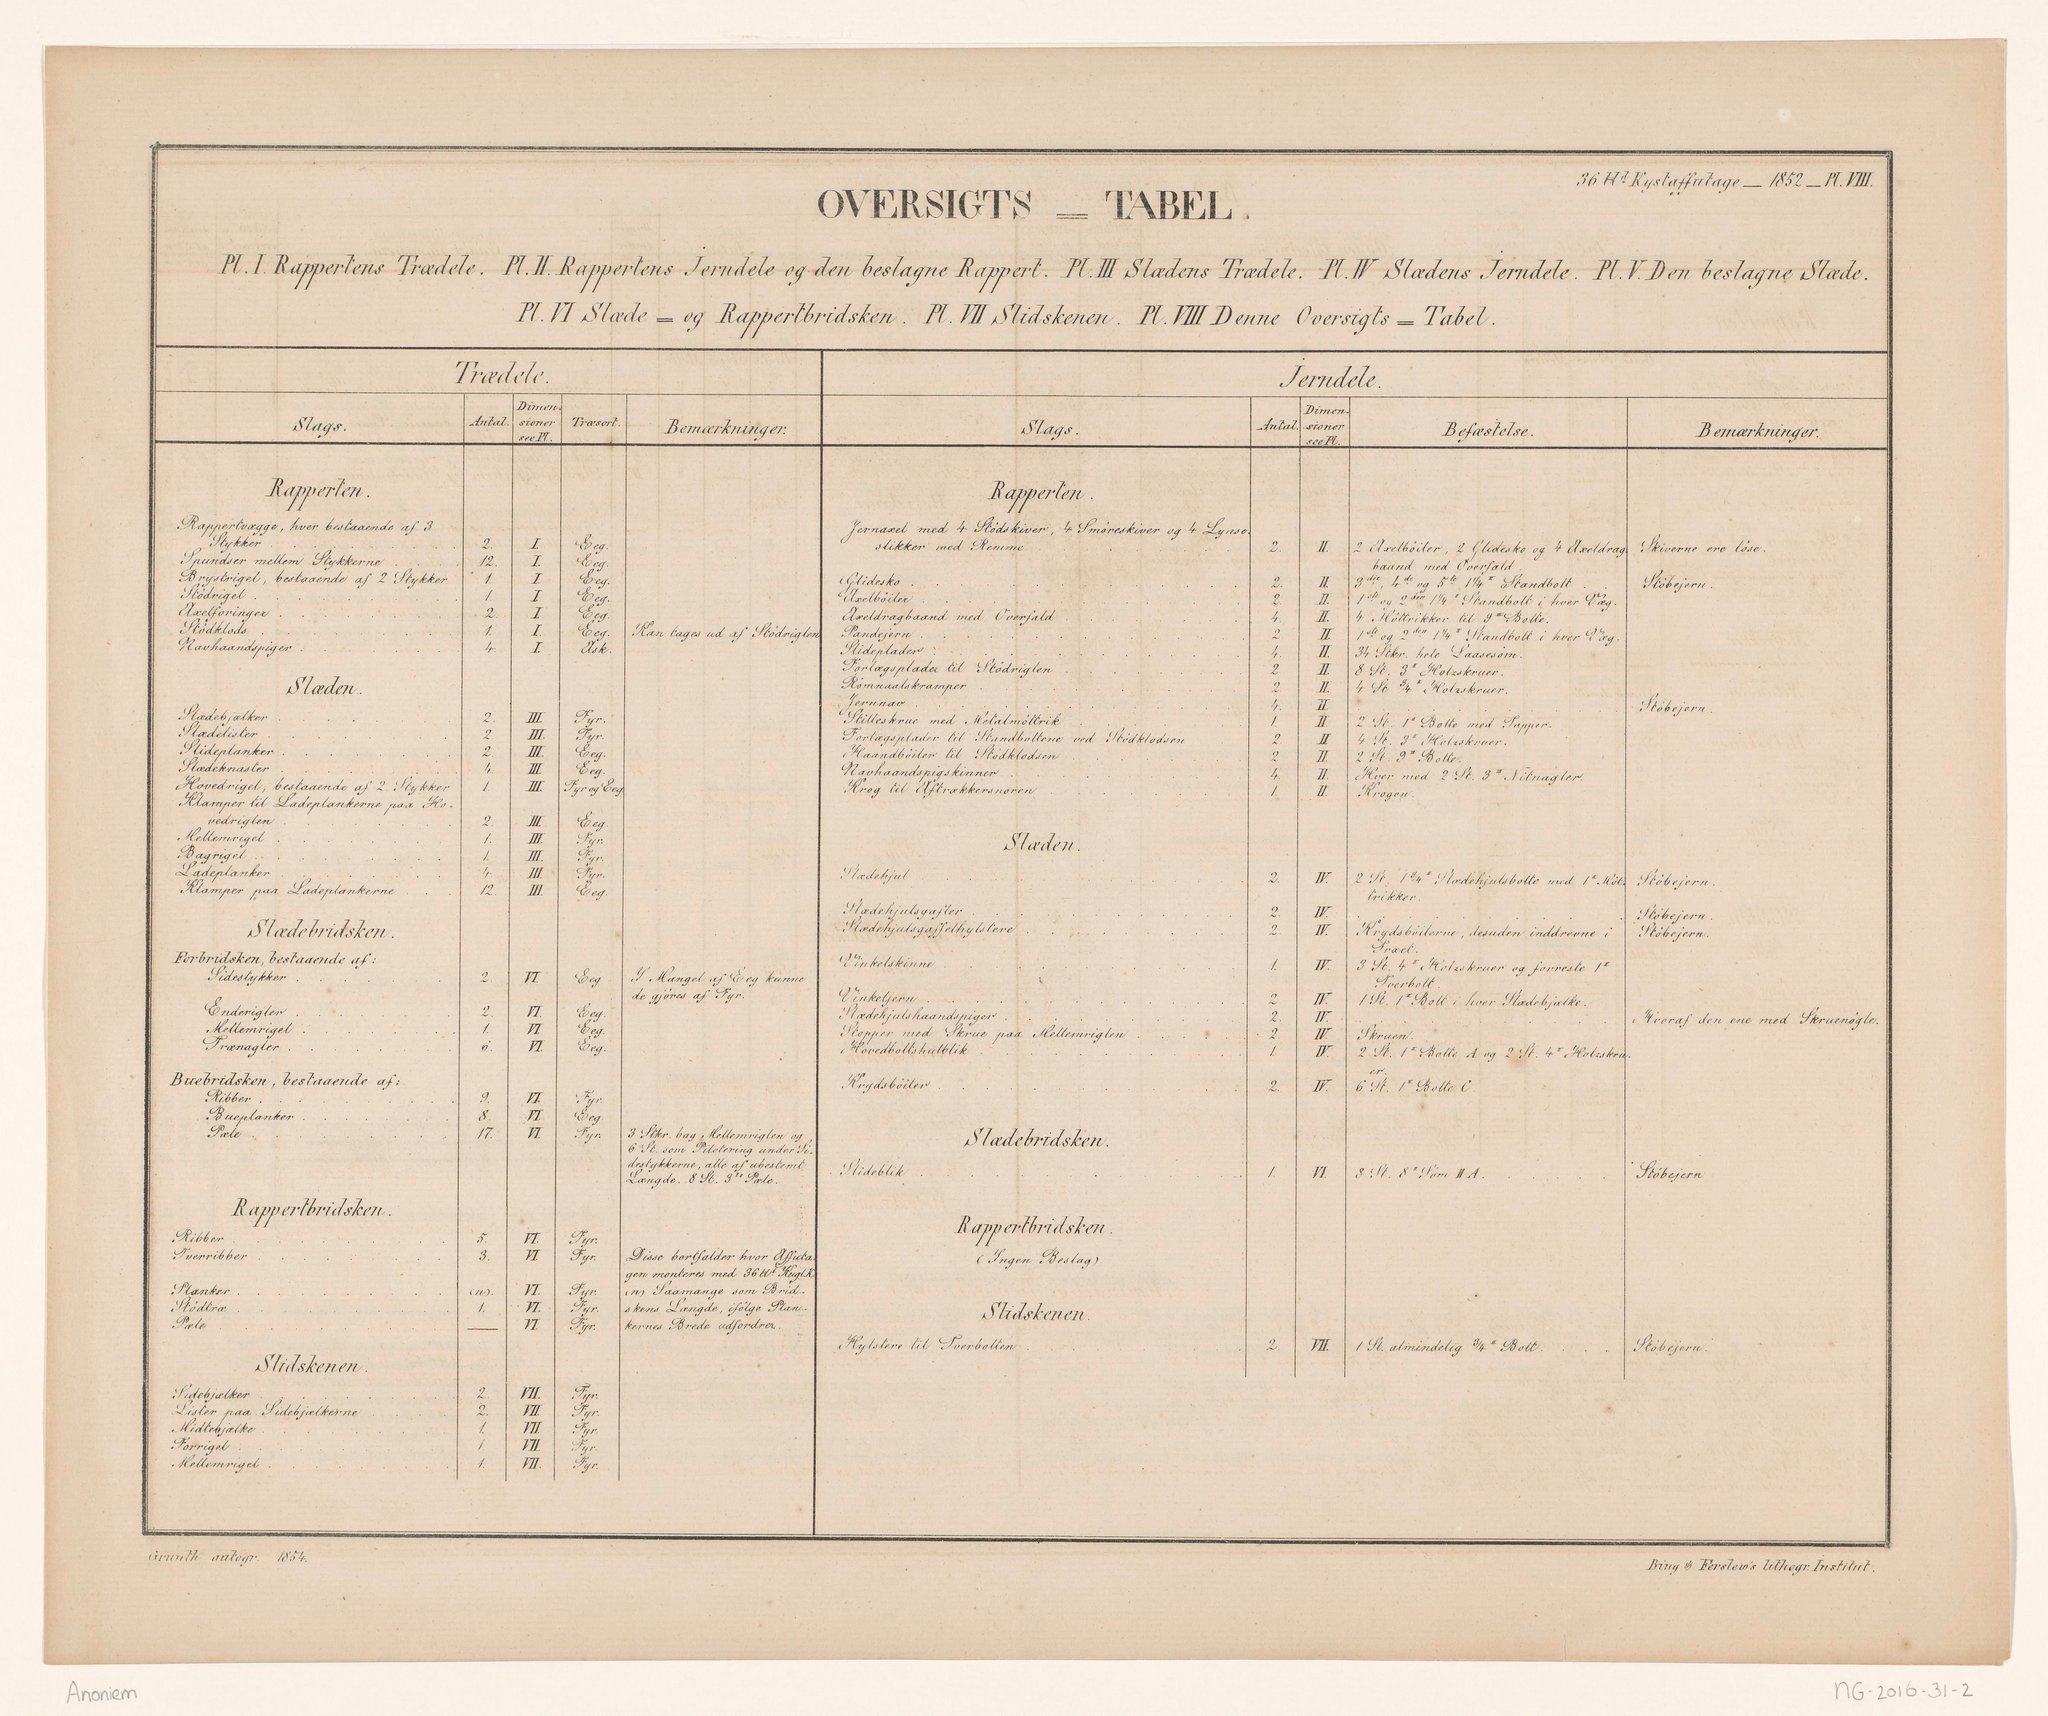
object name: print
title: Oversigts tabel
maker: Anonymous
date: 1854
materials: ink, paper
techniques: lithograph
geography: copenhagen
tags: statistic diagram, graph; pictorial chart, etc.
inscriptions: inscription: ‘Oversigts tabel. Pl. I Rappertens Trædele. Pl. II Rappertens jerndele og den beslagne rappert. Pl. III Slædens Trædele. Pl. IV Slædens Jerndele. Pl. V Den beslagne Slæde. Pl. VI Slæde og rappertbridsken. Pl. VII Slidskenen. Pl. VIII Denne oversigts tabel.’, inscription: ‘36 Hd. Kystaffutage - 1852 - Pl. VIII.’